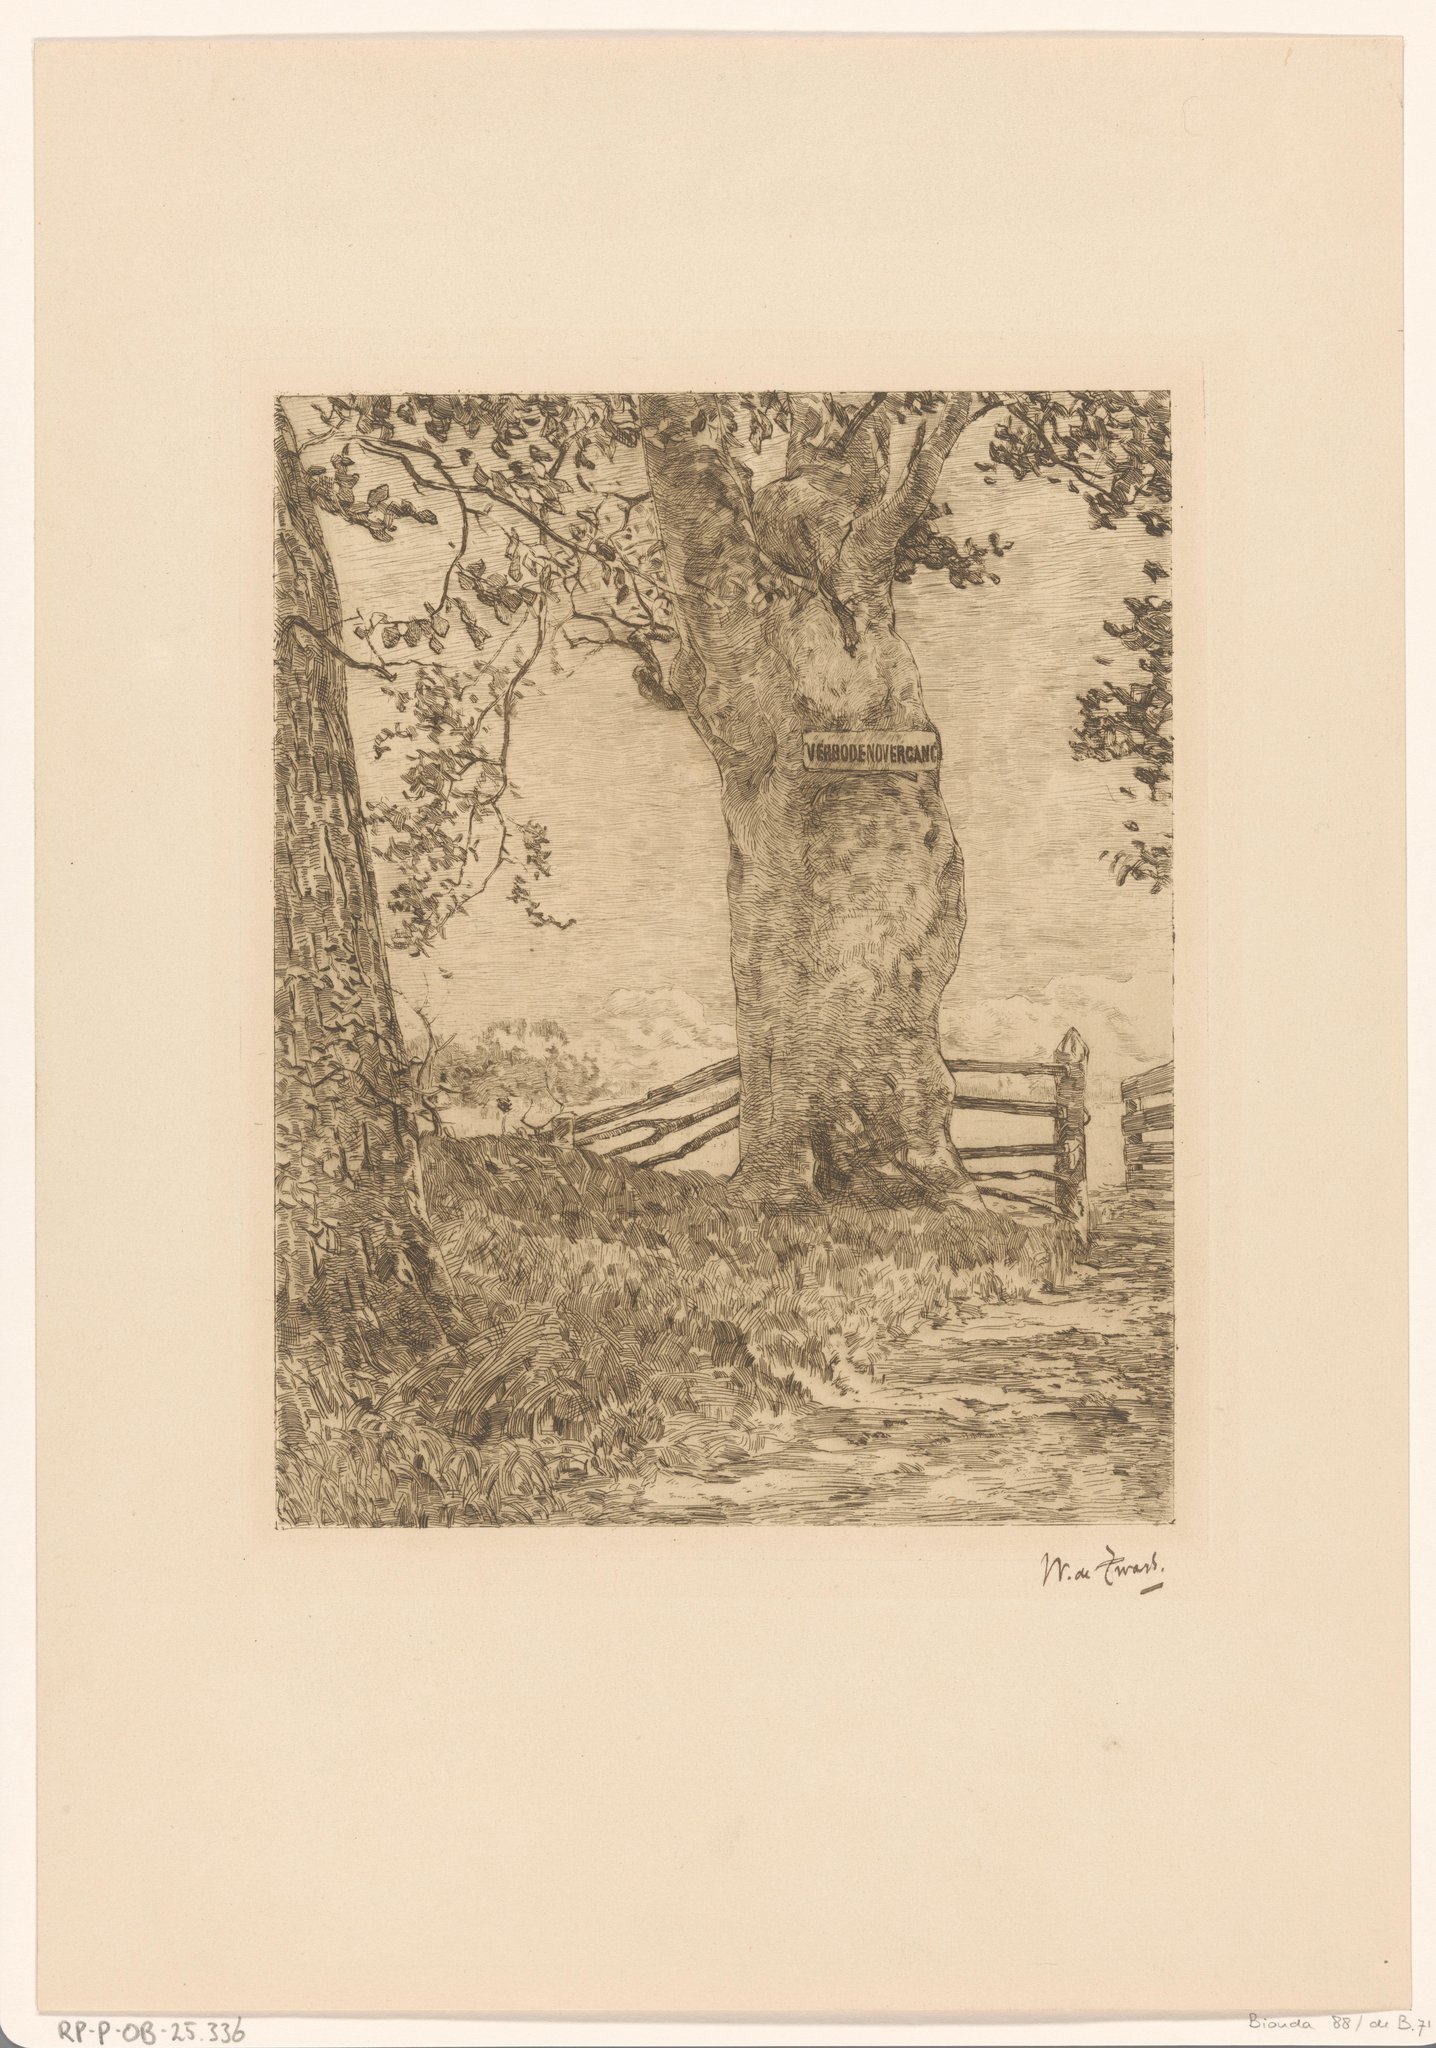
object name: print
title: Bomen bij een hek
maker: willem de zwart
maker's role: draughtsman, painter, print maker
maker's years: 1862-1931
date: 1896-1897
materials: paper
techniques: drypoint, etching, intaglio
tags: trees, fence, wall, paling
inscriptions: collector's mark: Lugt 2228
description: Deze prent is ook verschenen in: Portefeuille der Hollandsche Prentkunst. Amsterdam: Scheltema & Holkema, 1898.